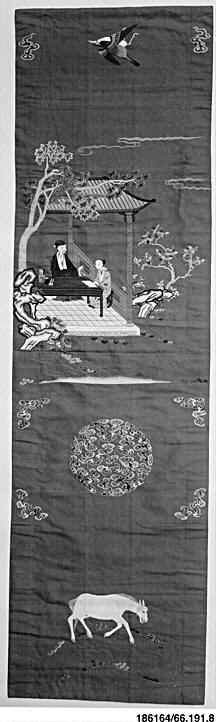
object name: chair strip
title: One of a Set of Twelve Chair Strips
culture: chinese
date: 1736-1795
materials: metal thread, silk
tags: birds,men,women